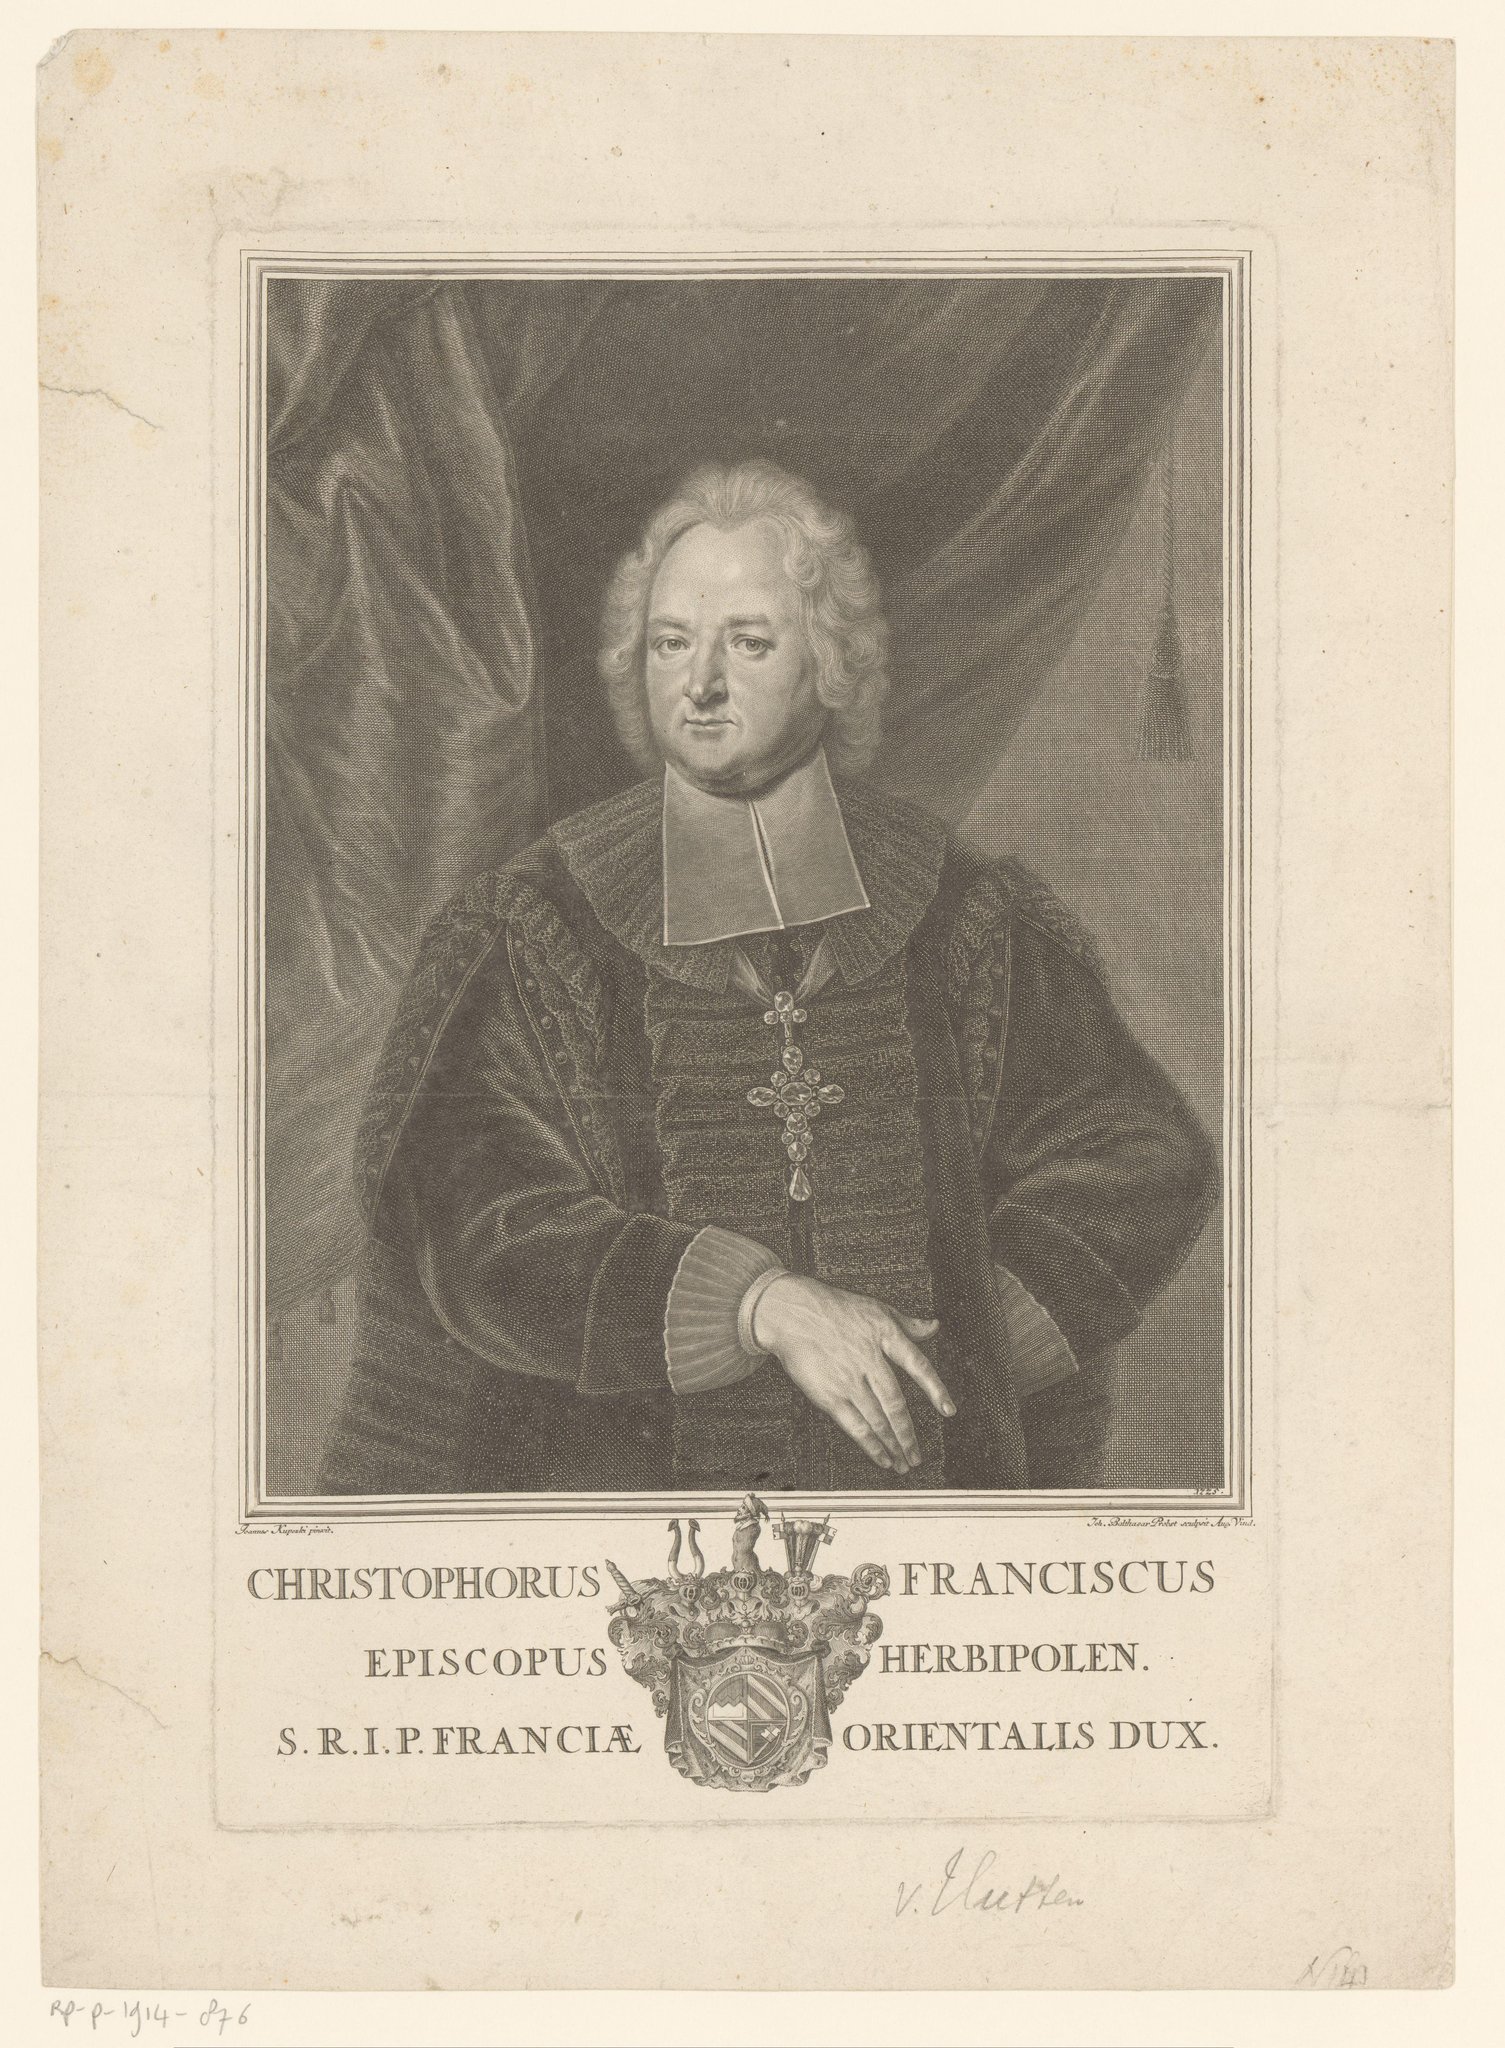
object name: print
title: Portret van Christoph Franz von Hutten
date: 1725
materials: paper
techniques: engraving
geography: augsburg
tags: theologian, crucifix ~ personal devotion, armorial bearing, heraldry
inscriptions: name, collector's mark: Lugt 2228